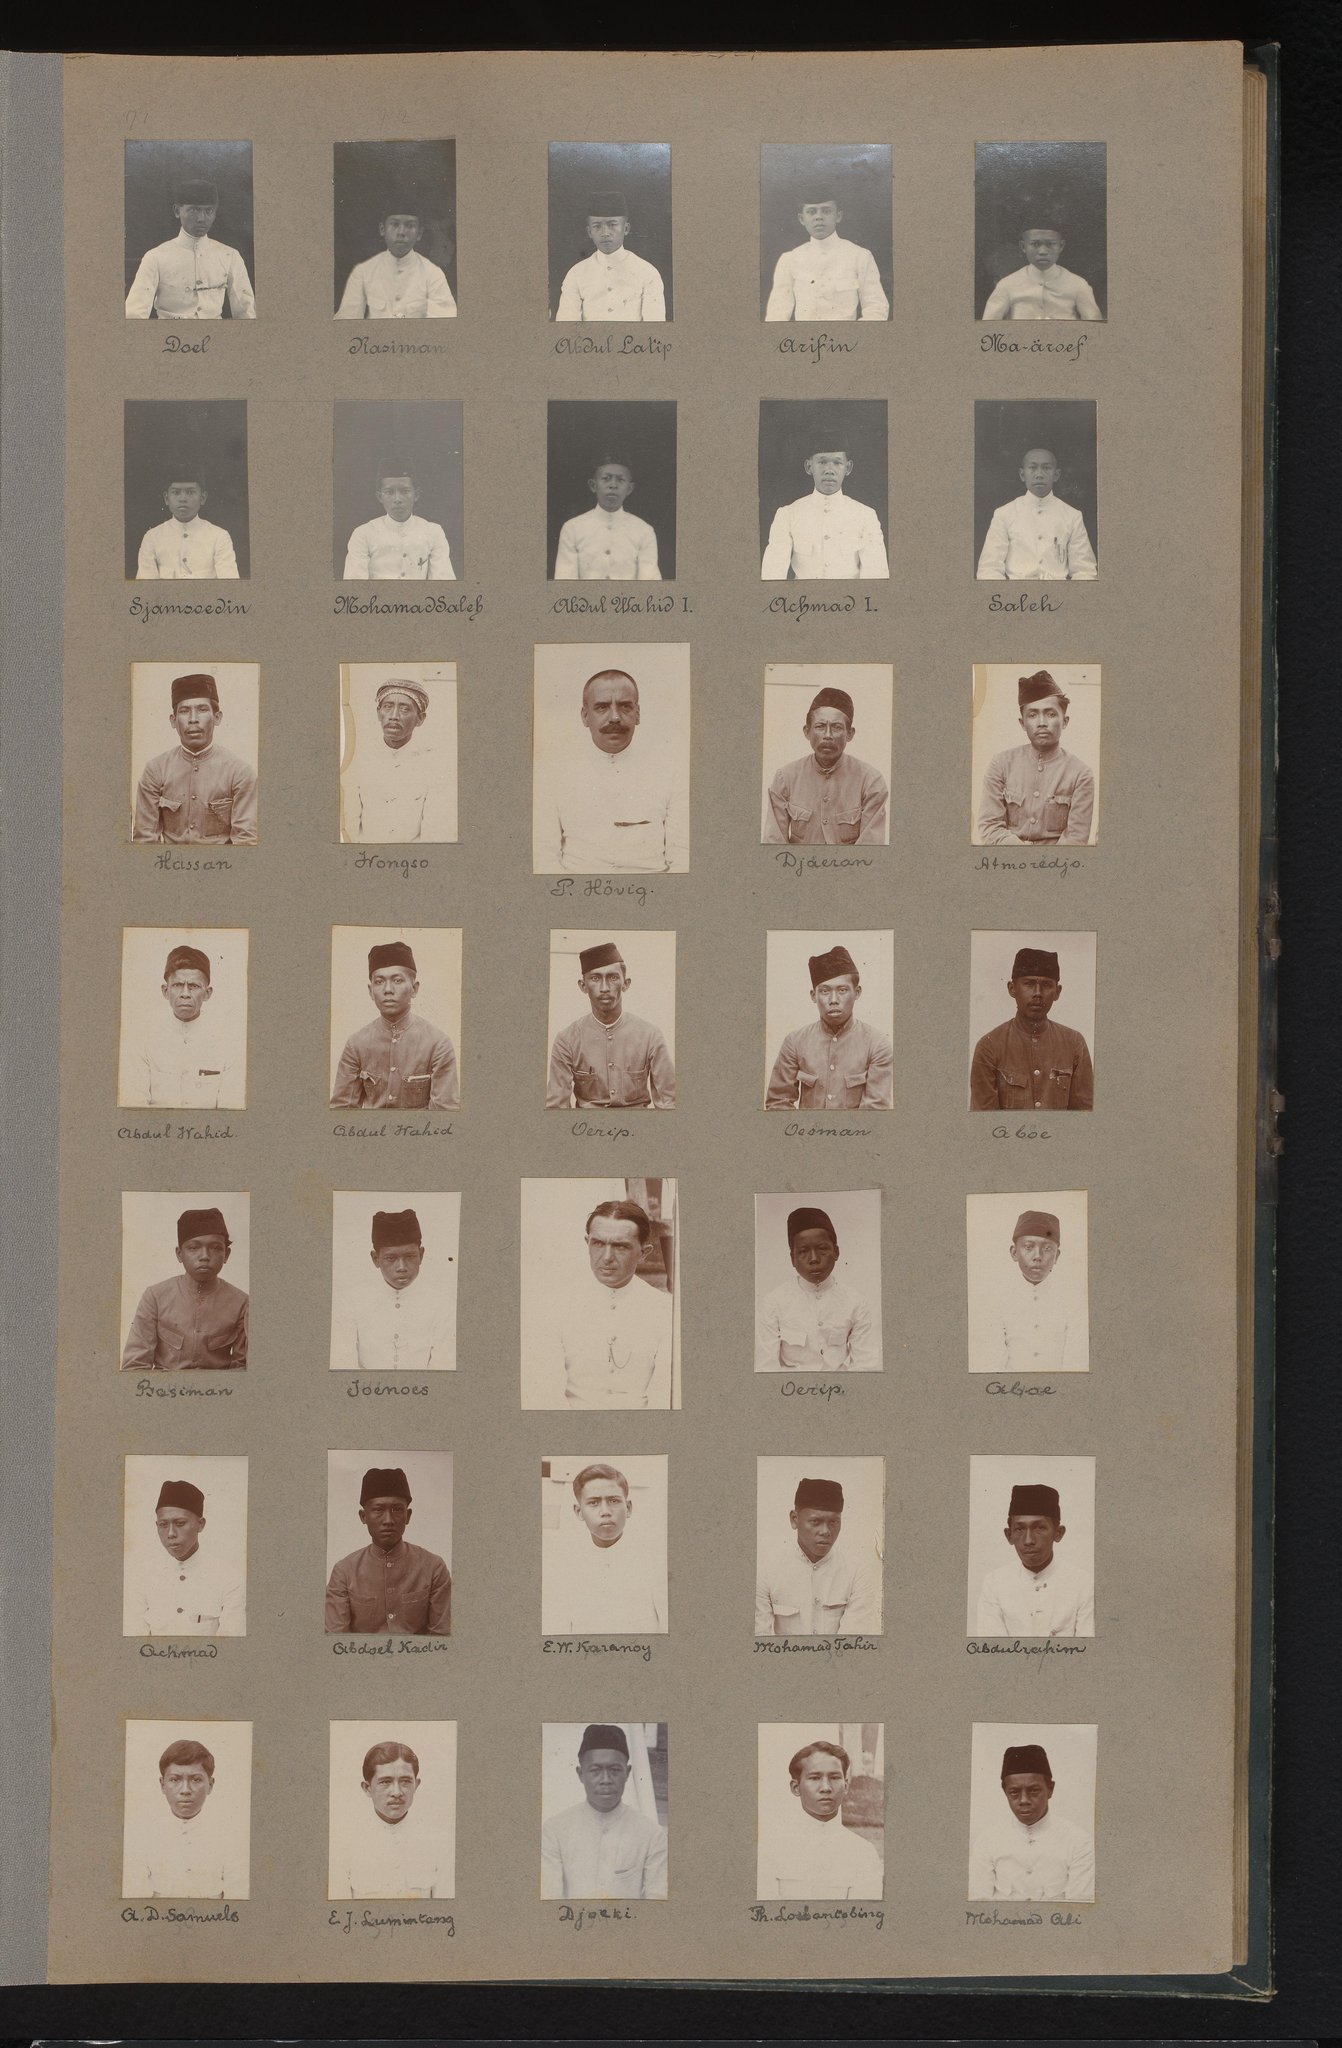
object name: photograph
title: Pasfoto's personeel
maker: Anonymous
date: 1914-1919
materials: cardboard, photographic support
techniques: gelatin silver print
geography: bangka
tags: robert julius boers, colonial system, mining, historical persons, industries ~ metal (+ men (labourers))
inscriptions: inscription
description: Albumblad met 35 kleine pasfoto's van personeel werkzaam bij het hoofdbureau van de Banka-tinwinning te Muntok. Portretten van Indonesische mannen en enkele Nederlanders, zonder aanduiding van functie. Onder de foto's de naam van de geportretteerde. Onderdeel van het fotoalbum aangeboden aan Robert Julius Boers bij zijn vertrek naar Nederland in 1919 door het personeel van de Banka-tinwinning.